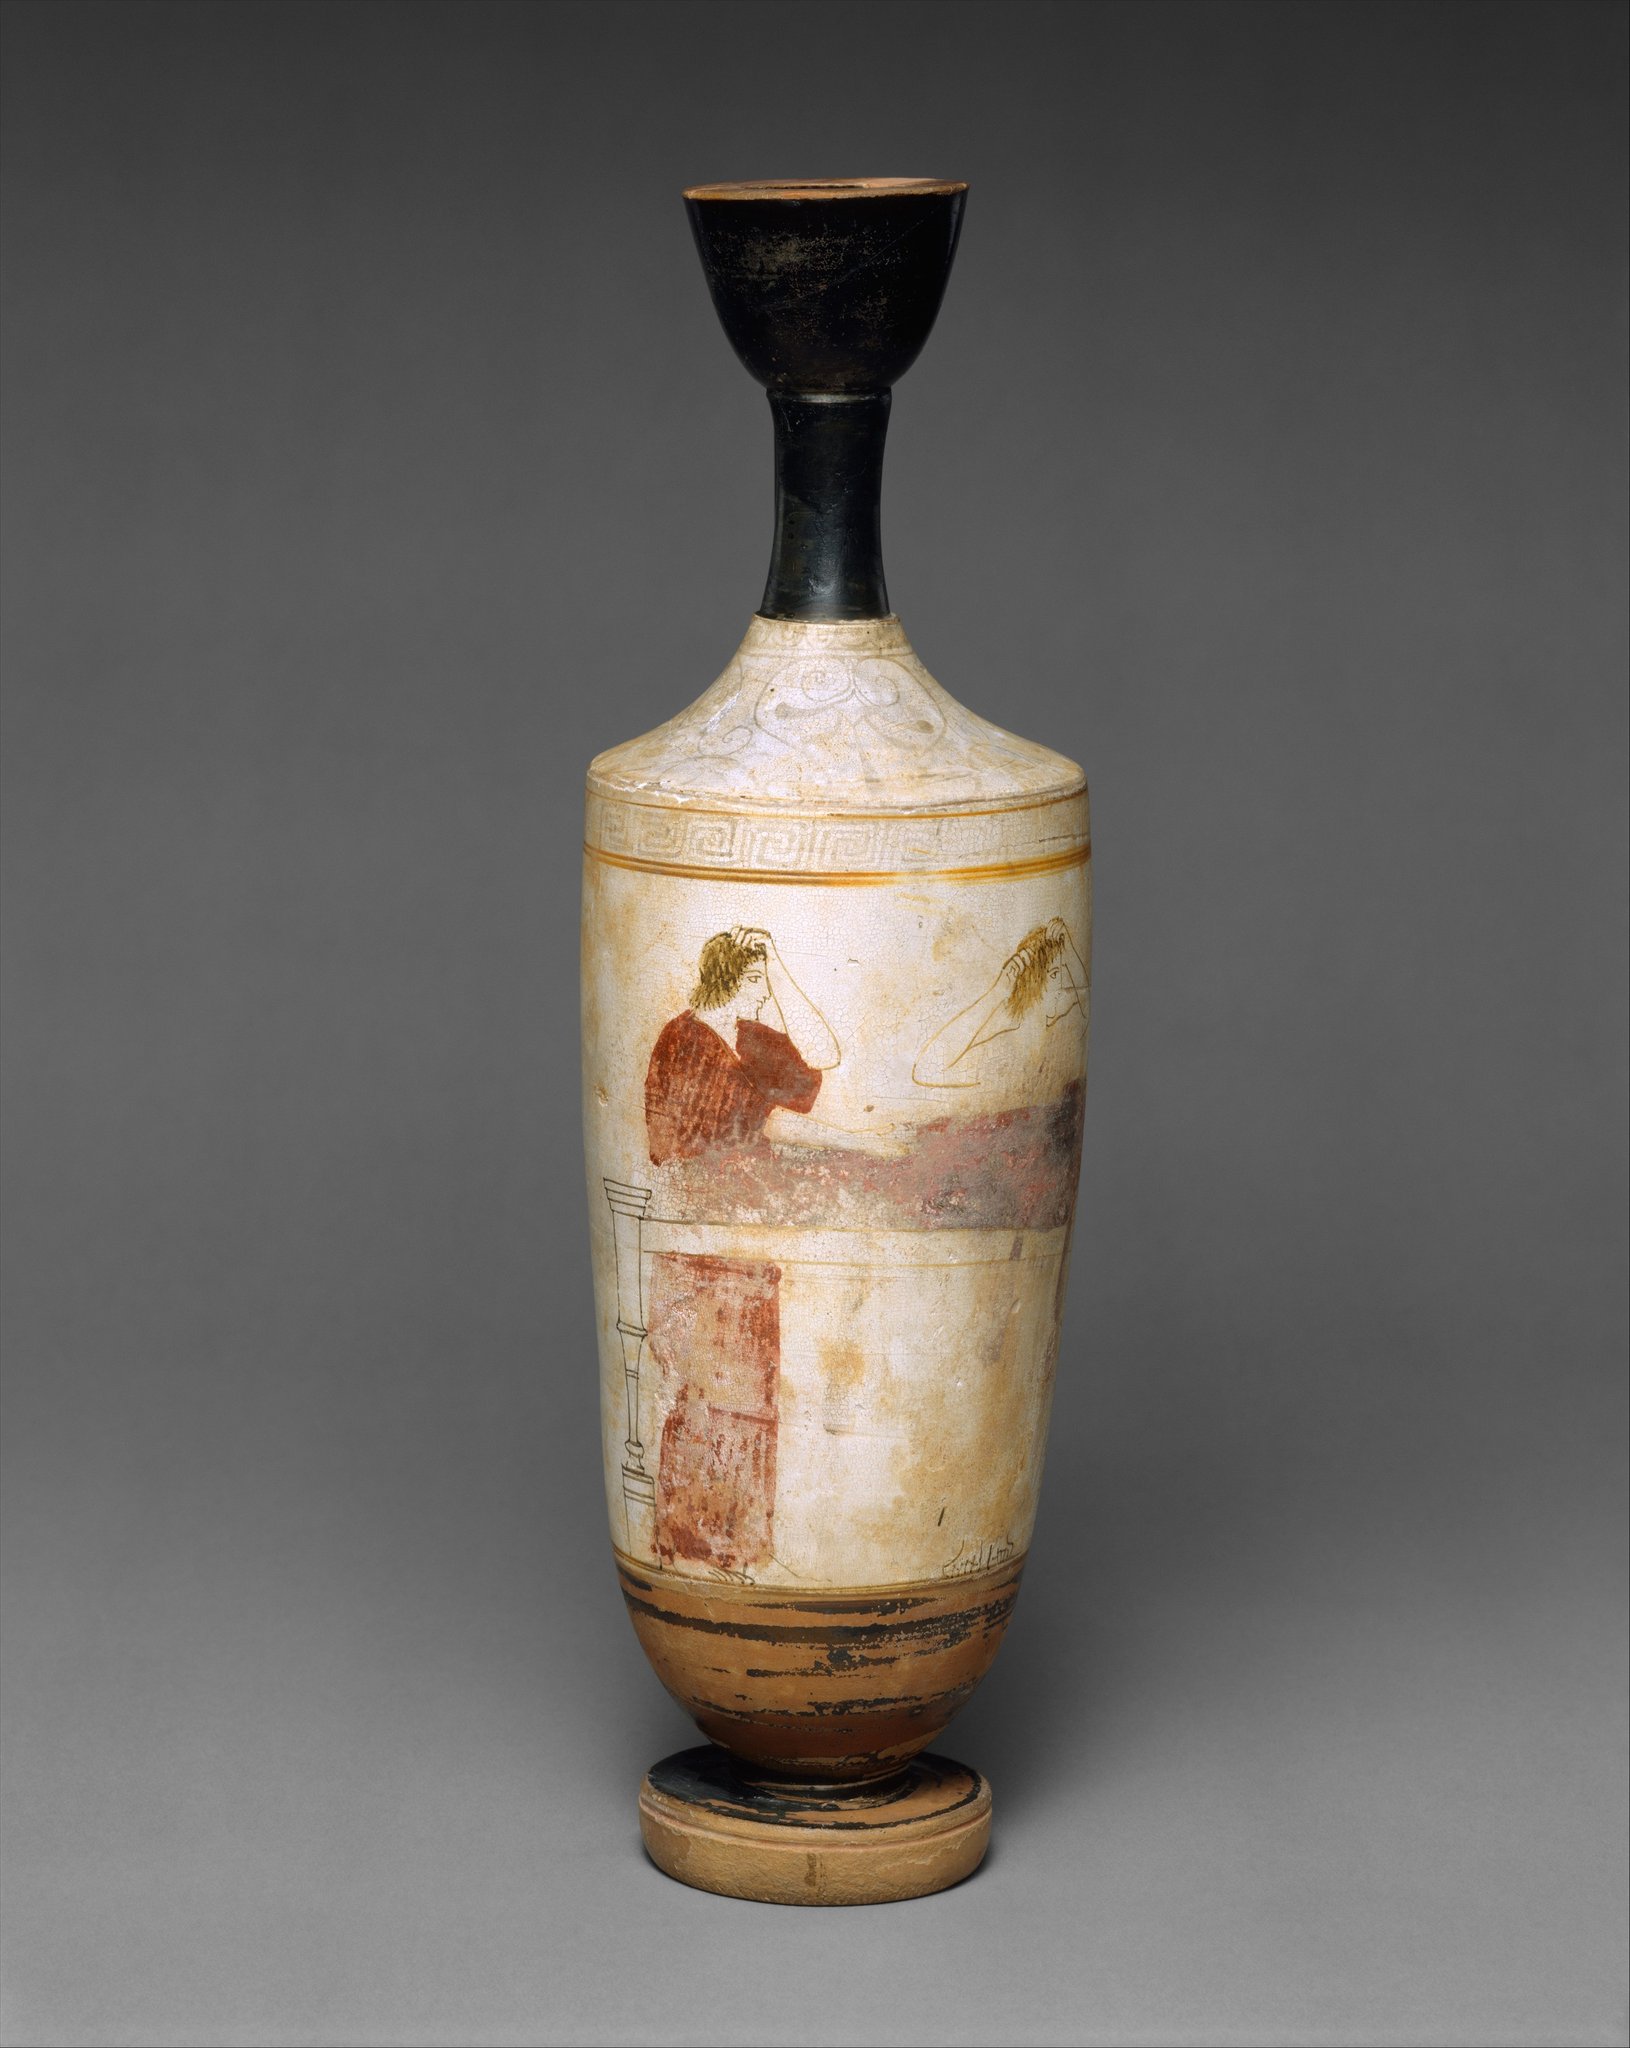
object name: lekythos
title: Terracotta lekythos (oil flask)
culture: greek, attic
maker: sabouroff painter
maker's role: artist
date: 450 BCE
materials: terracotta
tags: men,funerals